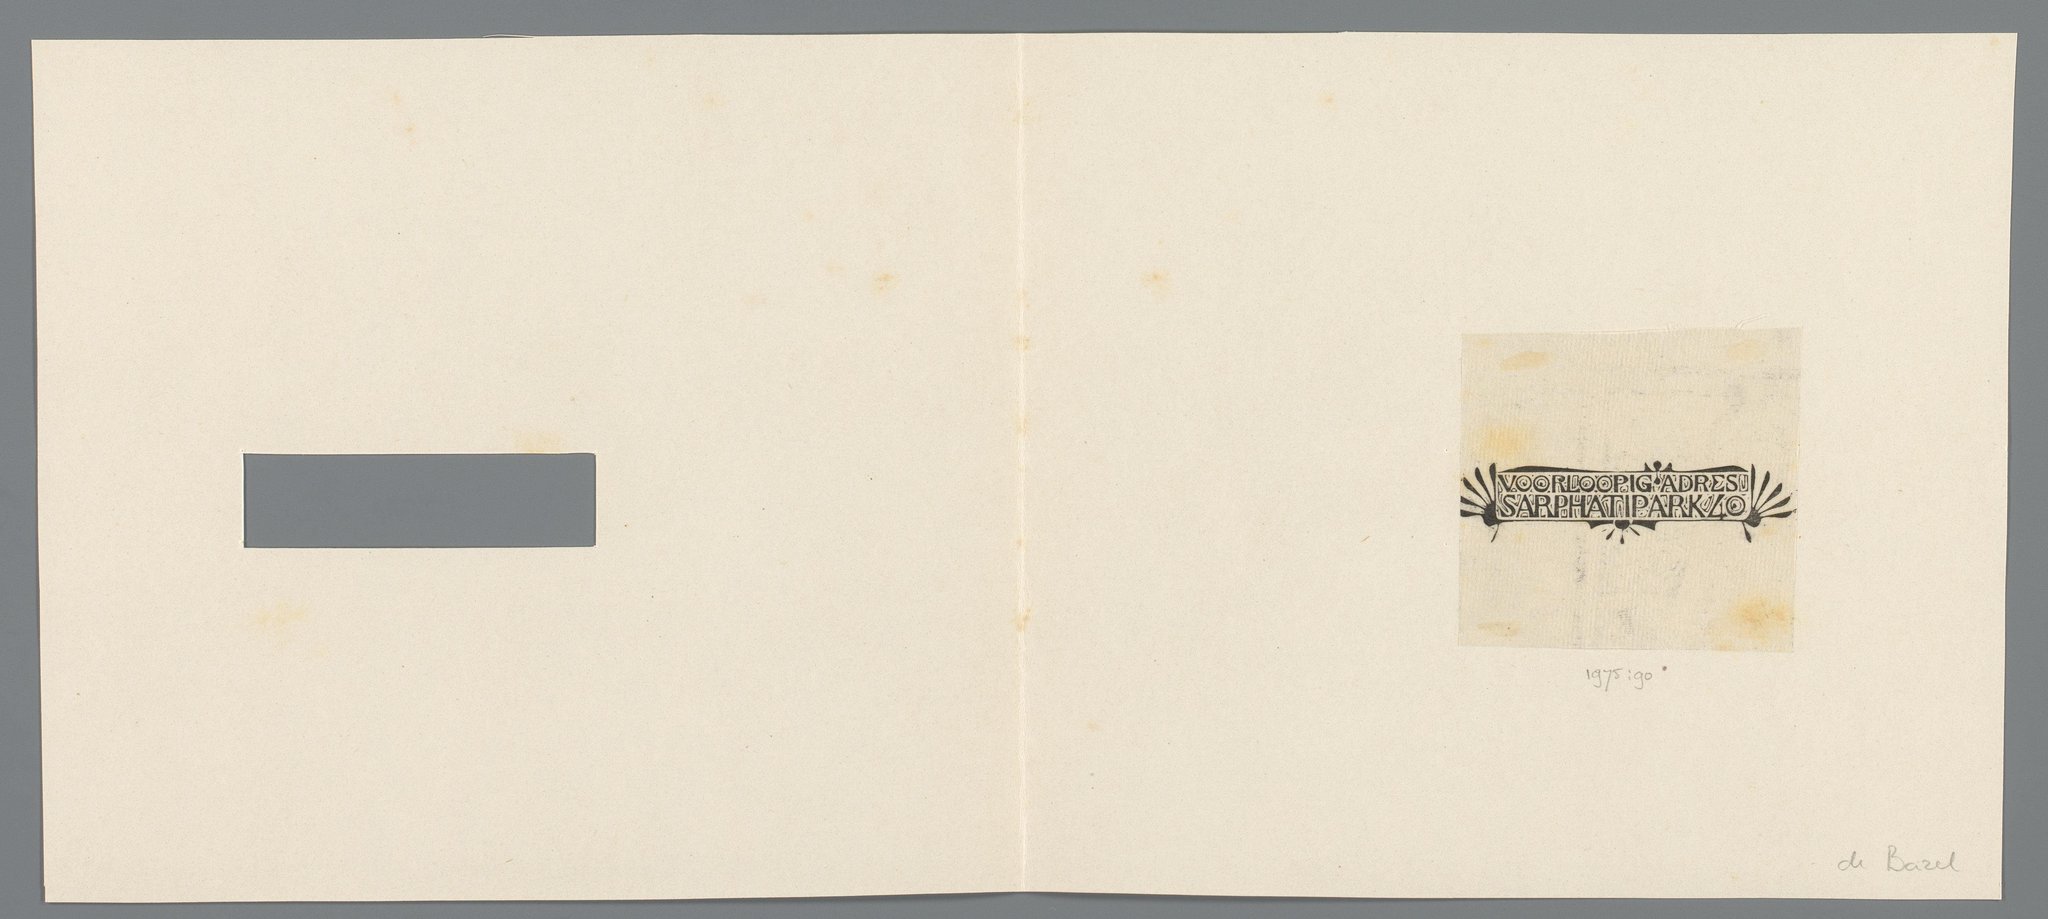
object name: print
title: Aankondiging van voorlopig adres van Karel de Bazel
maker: karel petrus cornelis de bazel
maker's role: draughtsman, print maker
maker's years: 1869-1923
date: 1895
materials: paper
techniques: woodcut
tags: den helder, amsterdam, print maker, draughtsman, karel petrus cornelis de bazel, visiting-card, calling-card, fancy letters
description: 'Voorloopig adres Sarphatipark 40' in een decoratief kader. Dit betrof het atelier van Karel de Bazel en Mathieu Lauweriks.